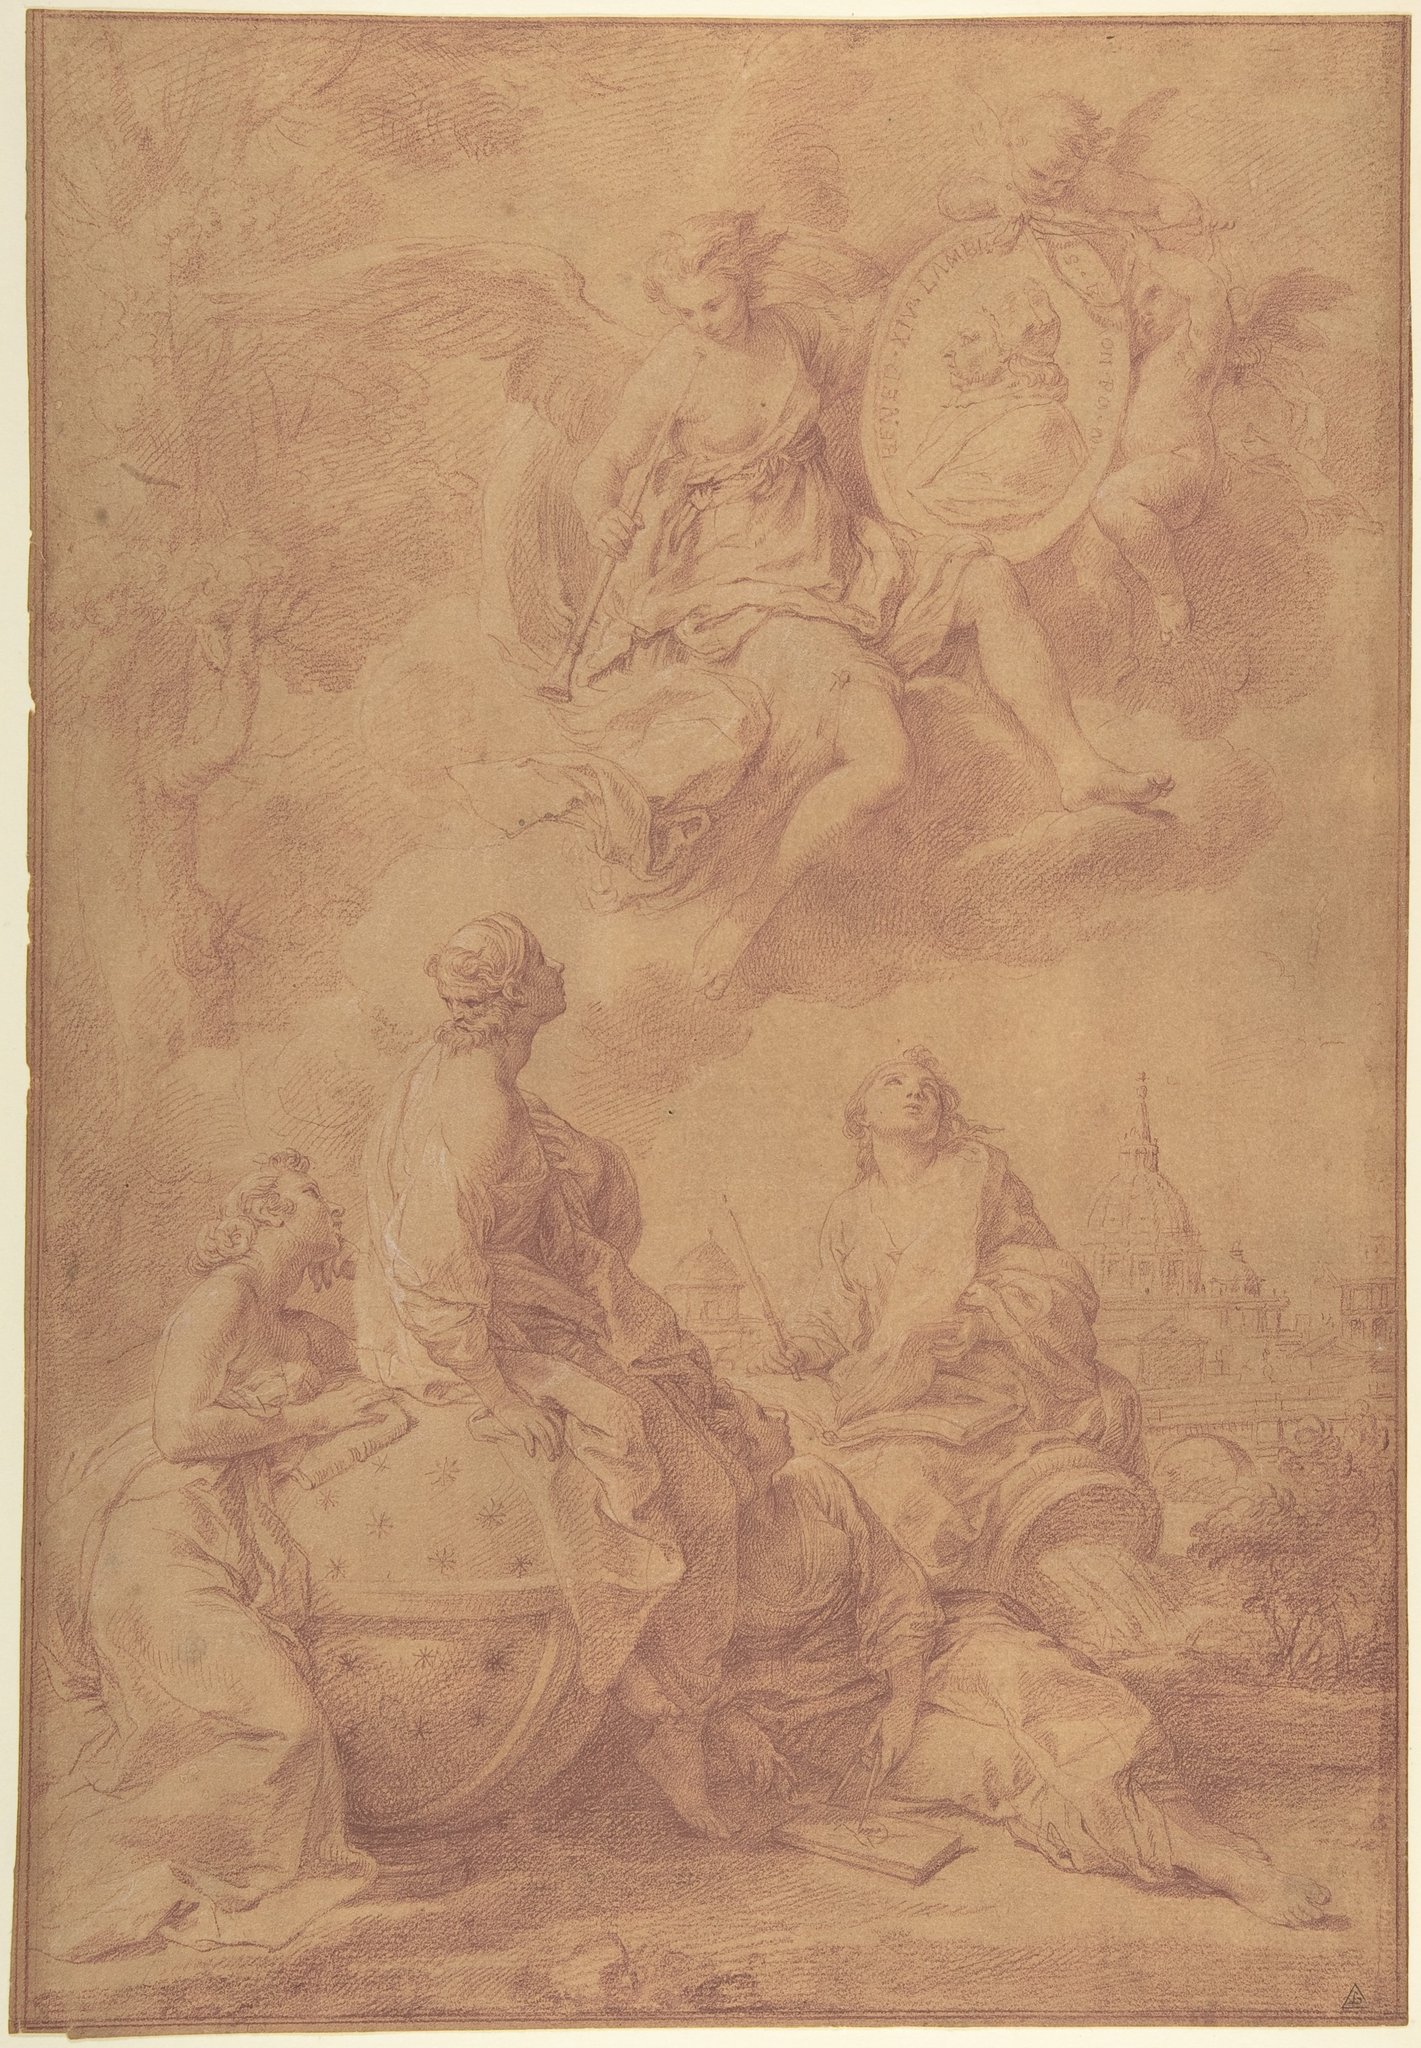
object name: drawing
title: Allegory in Honor of Pope Benedict XIV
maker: pompeo batoni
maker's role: artist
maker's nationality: italian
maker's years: 1708-1787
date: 1745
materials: chalk, paper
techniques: highlighting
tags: women,angels,popes